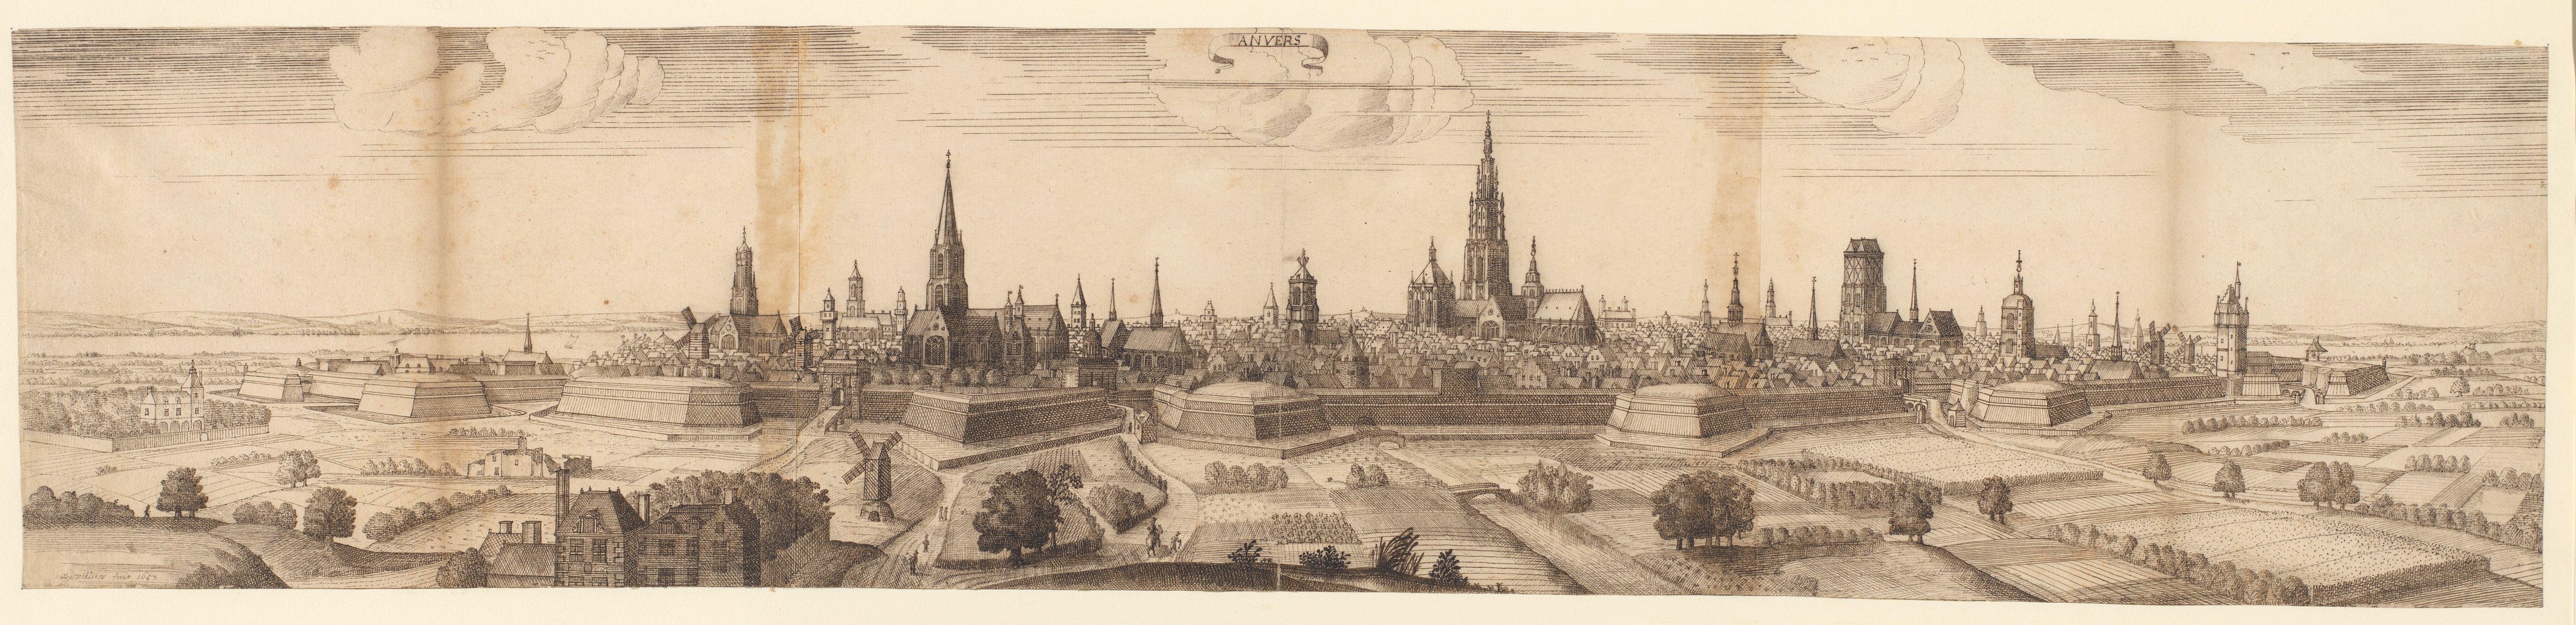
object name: drawing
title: Gezicht op Antwerpen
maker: jacob de villeers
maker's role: draughtsman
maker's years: 1616-1667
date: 1657-1658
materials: ink, paper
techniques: pen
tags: prospect of city, town panorama, silhouette of city, antwerp